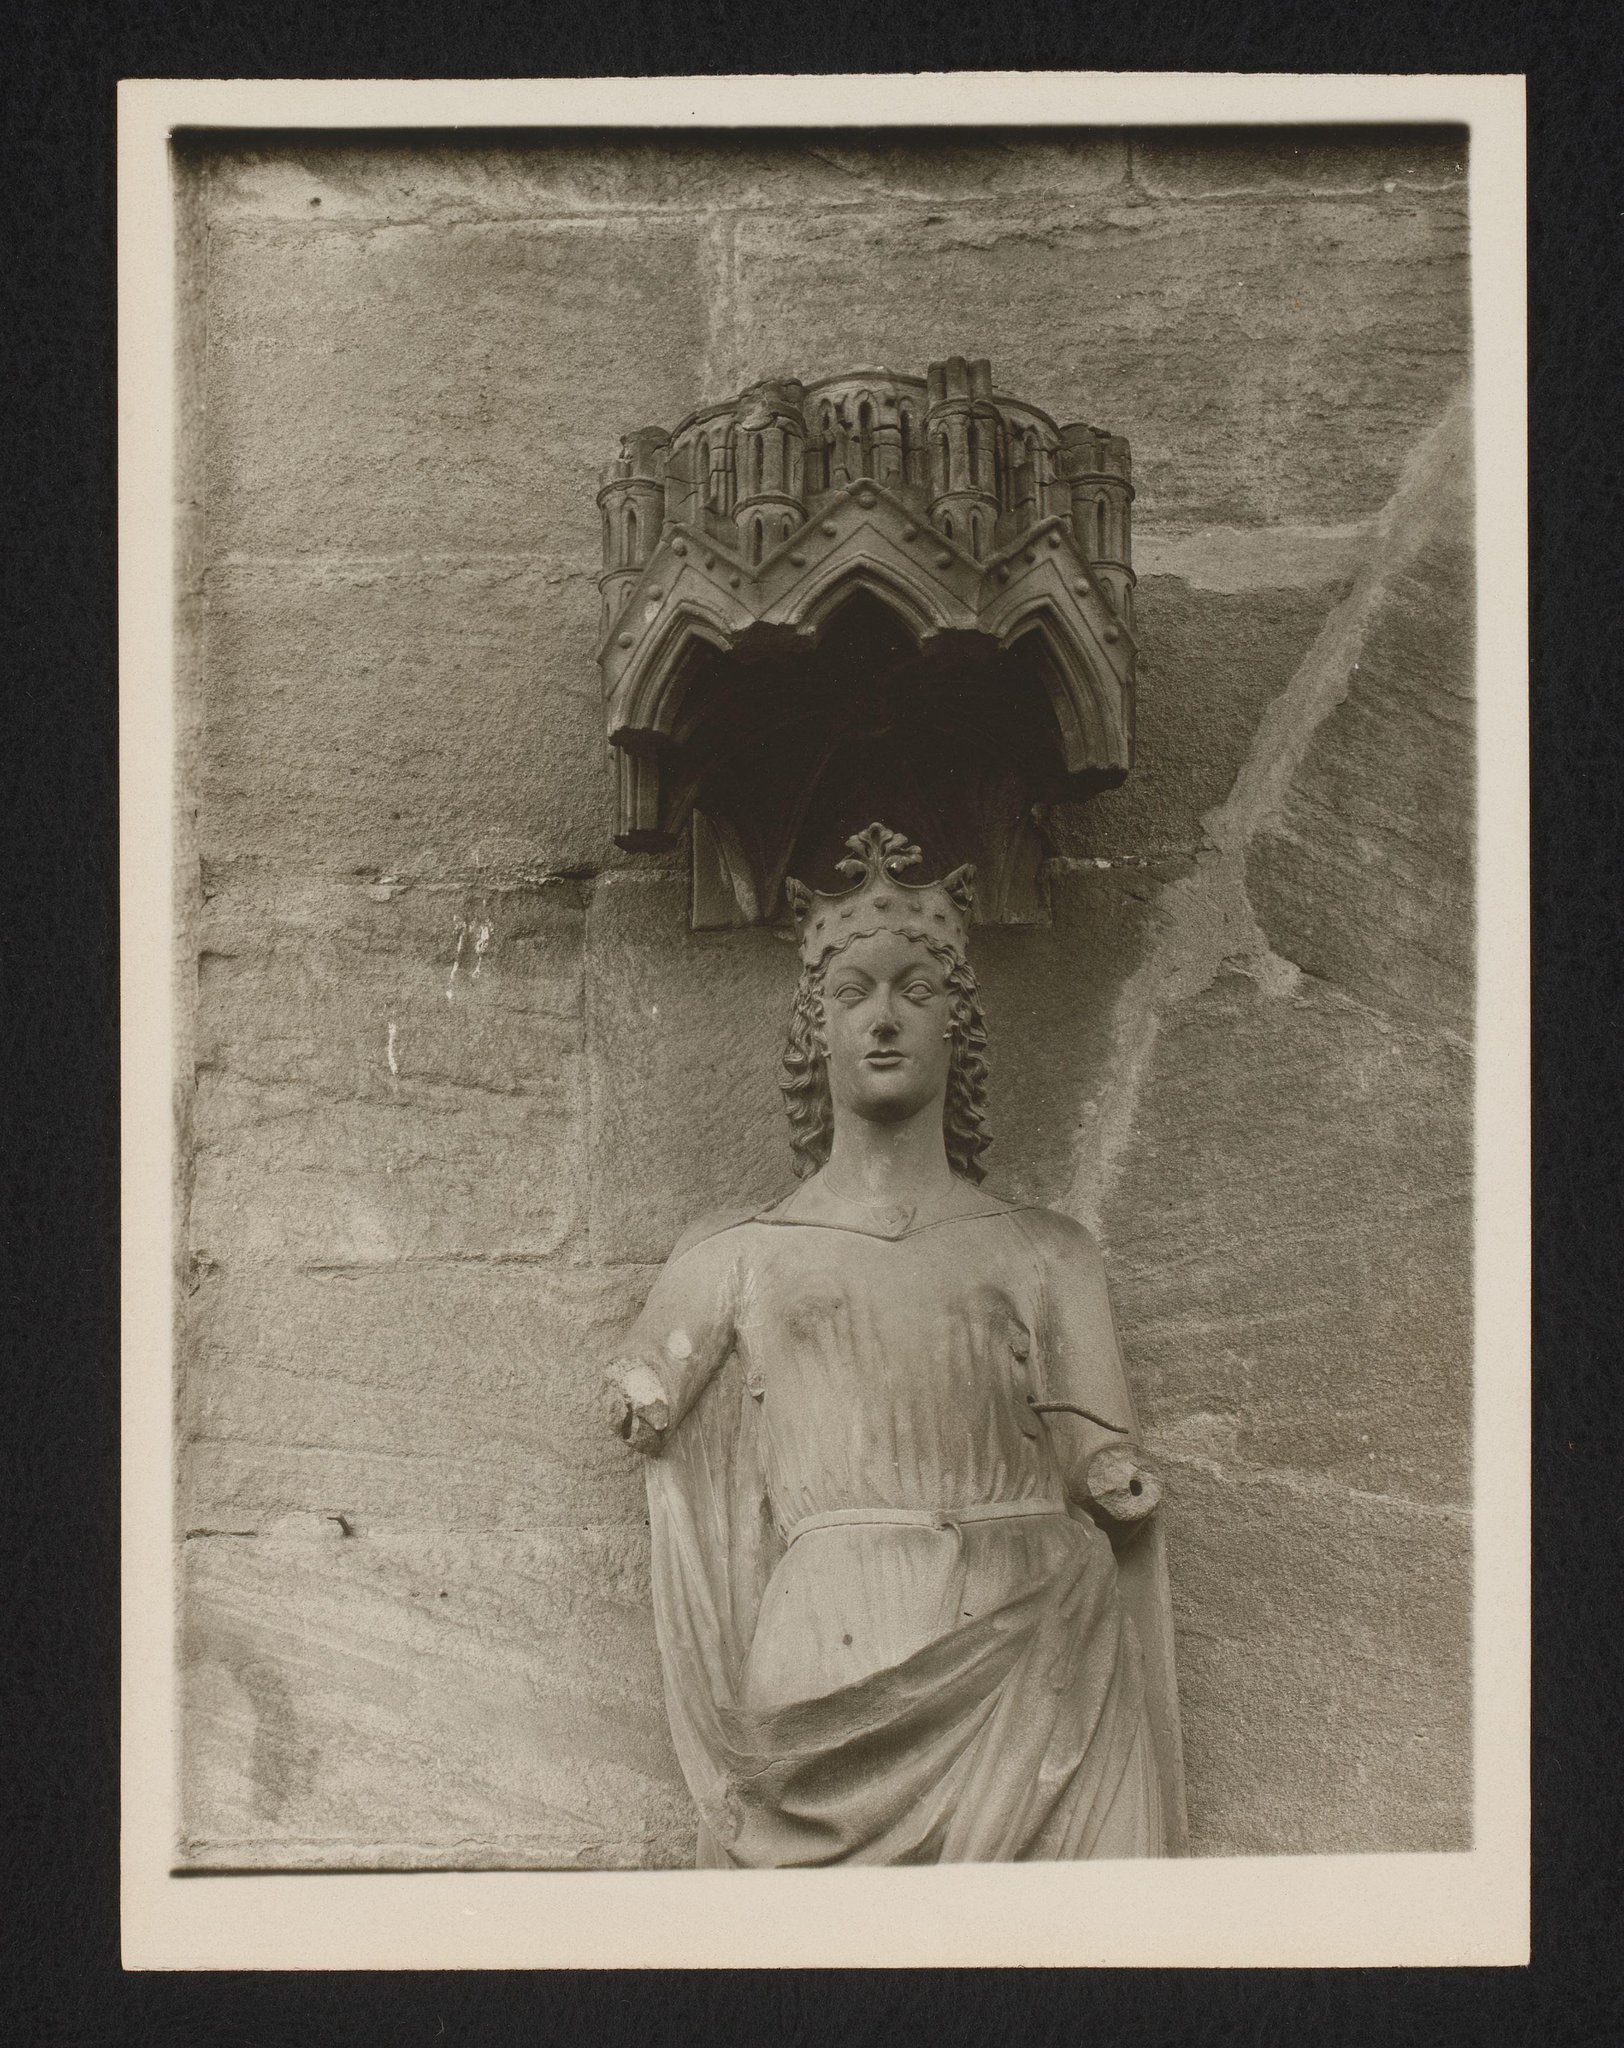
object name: album leaf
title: Detail van het Fürstenportal in de dom van Bamberg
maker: Anonymous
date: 1900-1920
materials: paper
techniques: gelatin silver print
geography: bamberg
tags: church (exterior)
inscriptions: number: ‘100’, inscription: ‘Kunsthist. Seminar/ Marburg (Lahn)/ Photogr. Abteilung/ Vervielfältigung/ untersagt.’